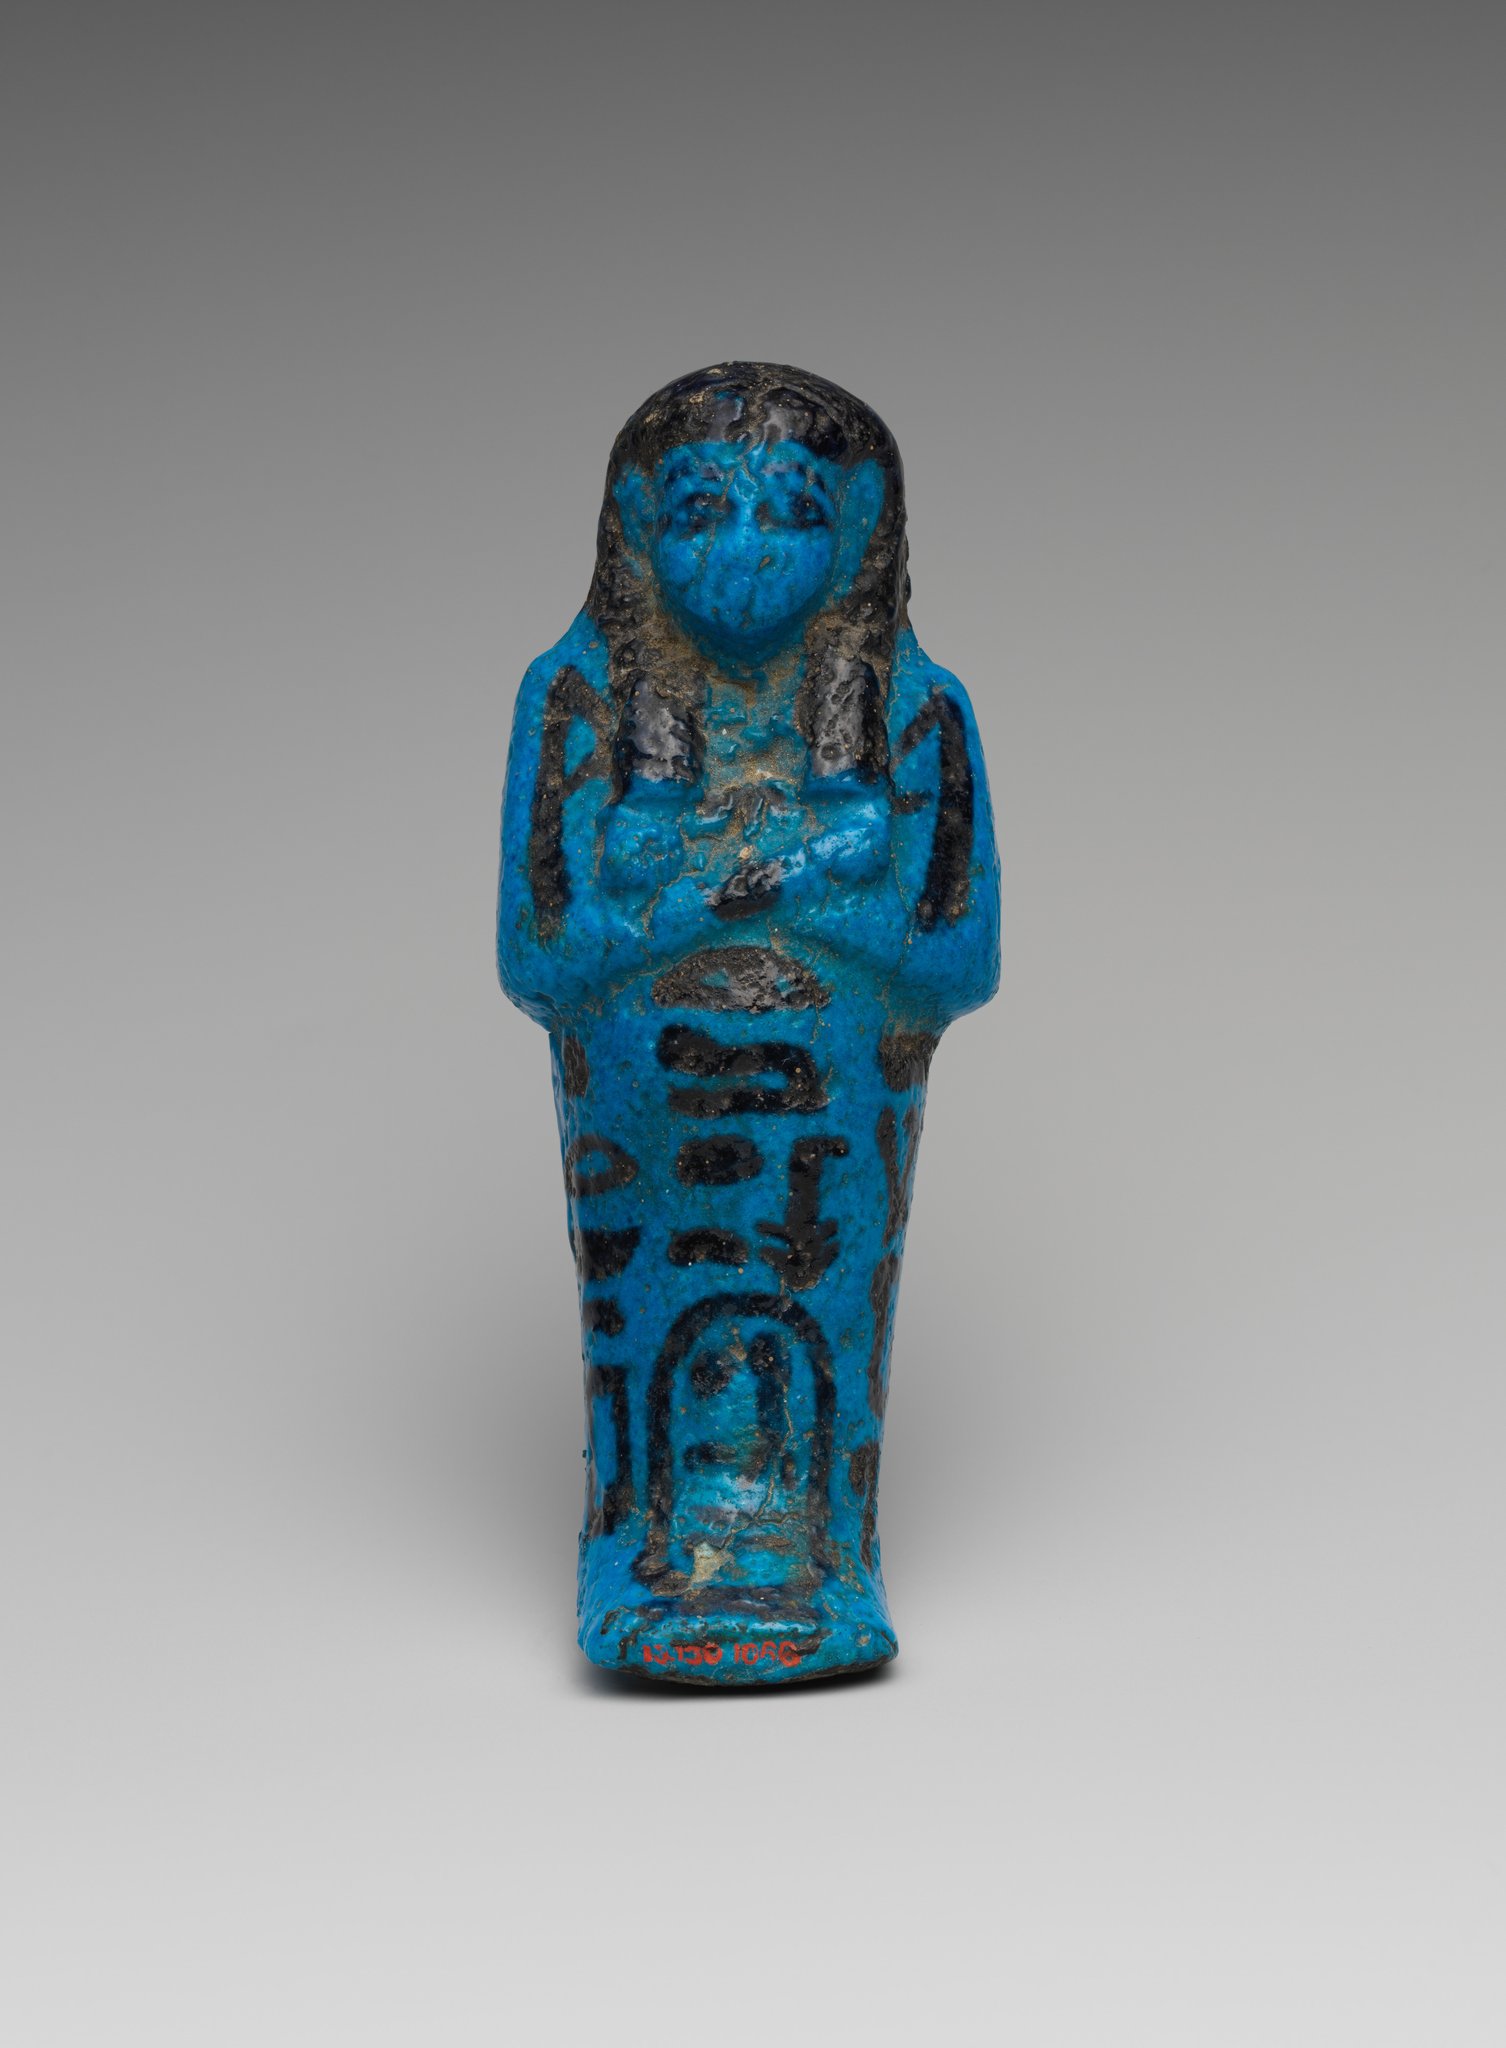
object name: shabti, queen henettawy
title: Shabti of the Adoratrice of Hathor Henettawy, wife of Painedjem I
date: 1064-1055 BCE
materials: faience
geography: upper egypt, thebes